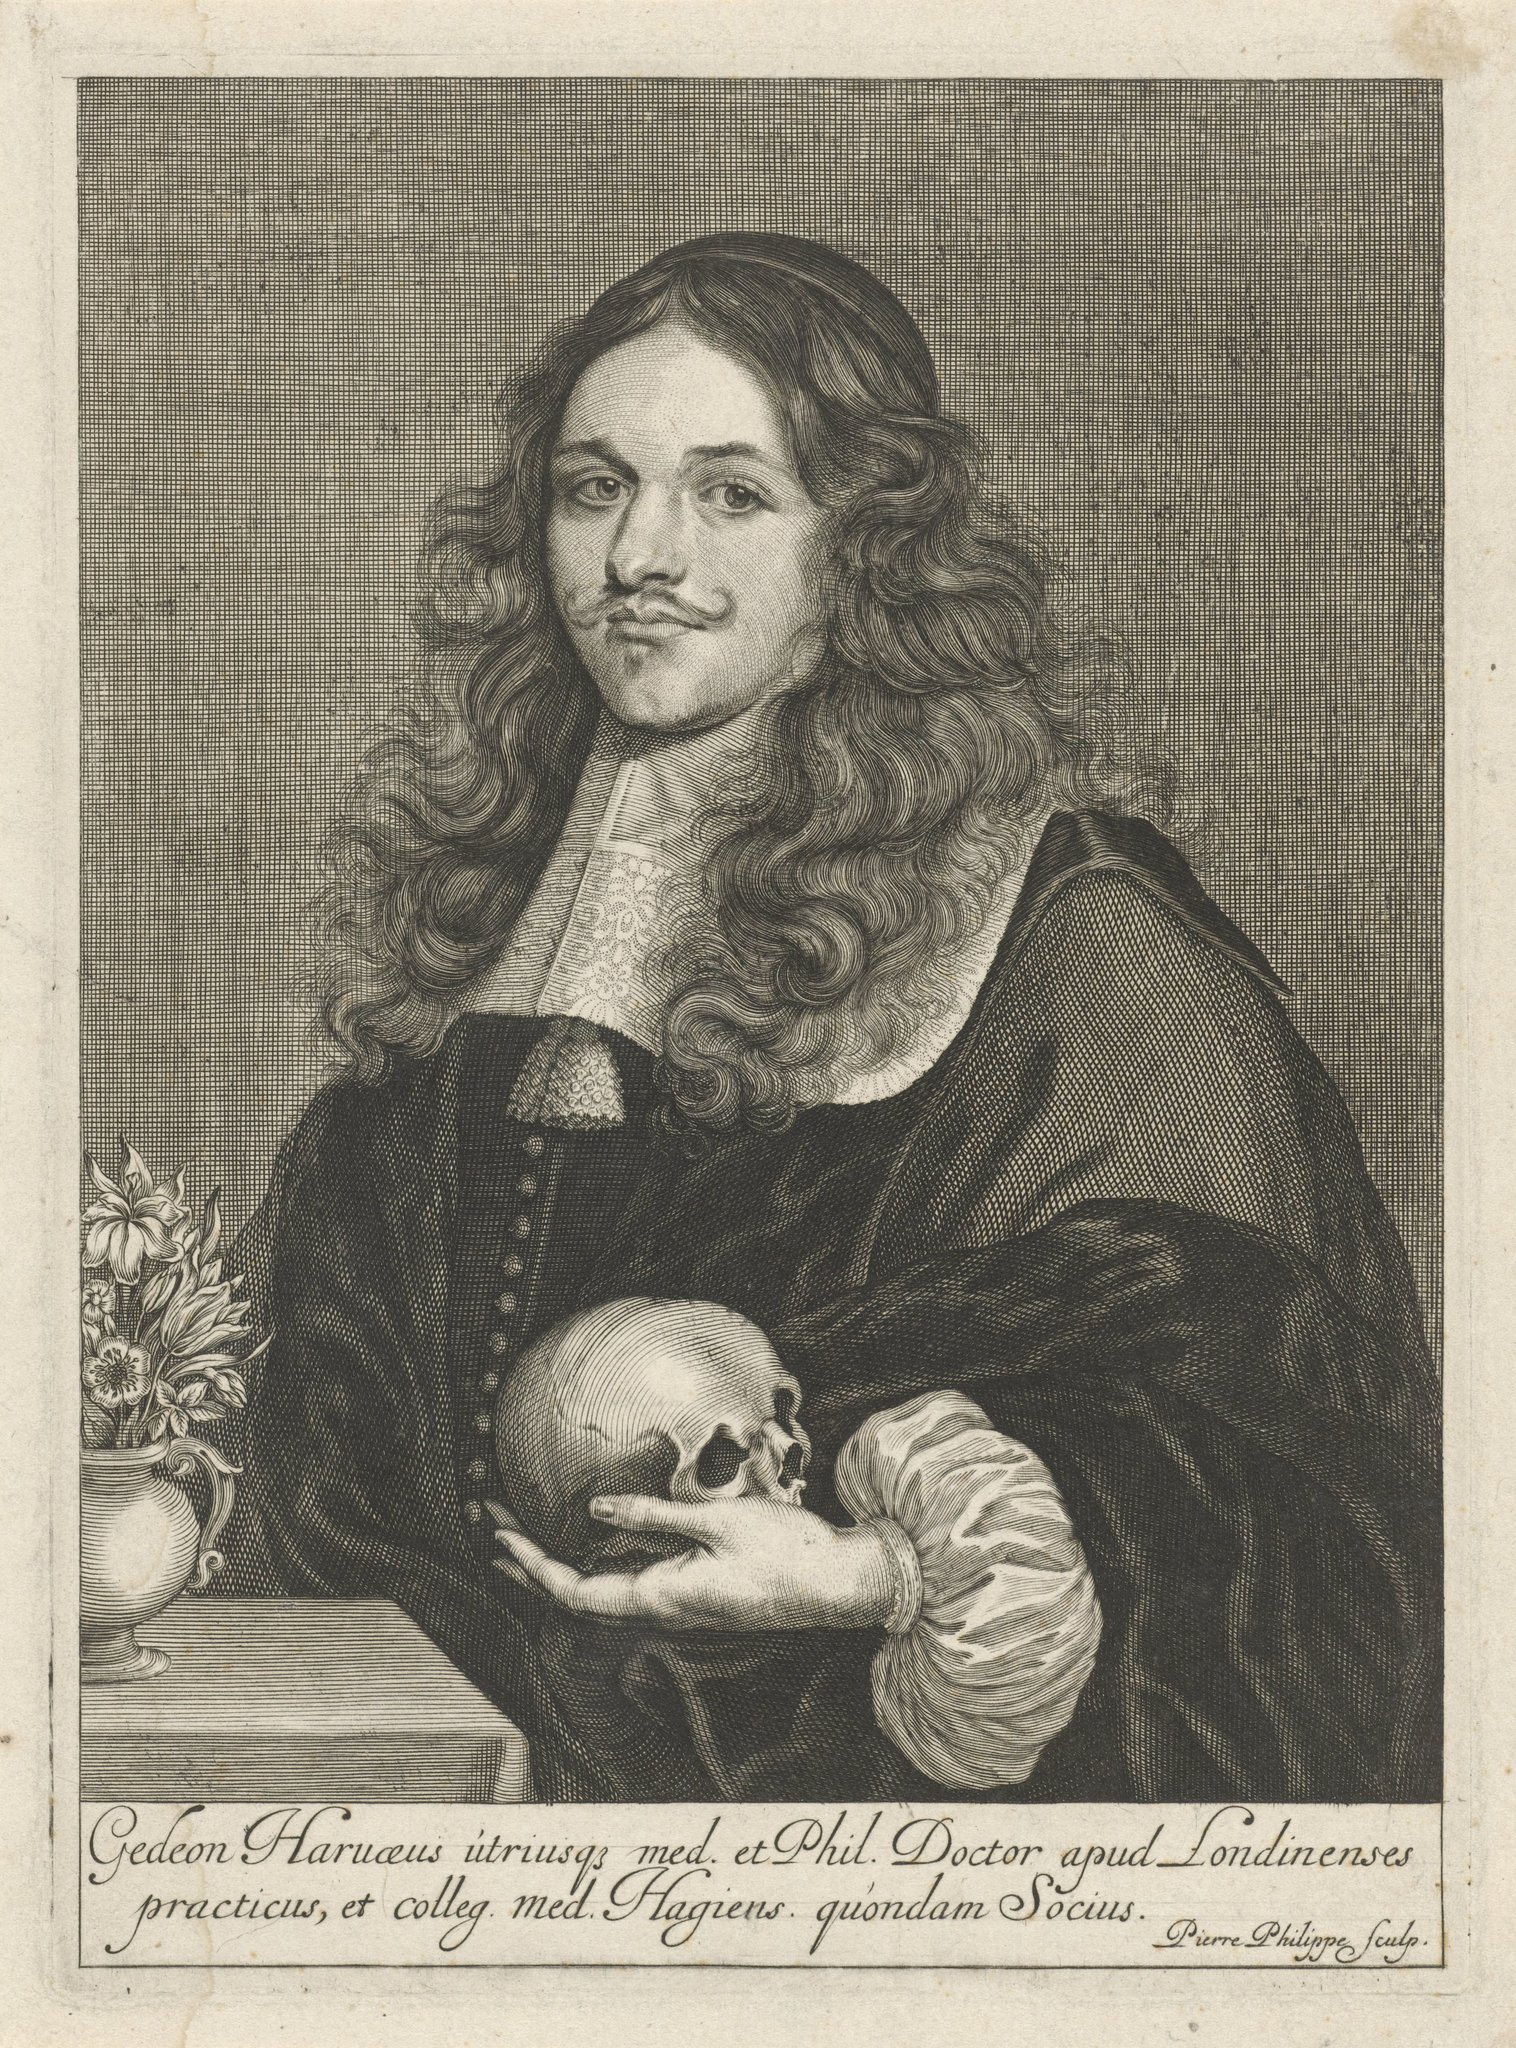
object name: print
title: Portret van Gideon Harvey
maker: pieter philippe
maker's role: print maker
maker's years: 1635-1702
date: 1663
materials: paper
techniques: engraving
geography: the hague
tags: skull as symbol of 'vanitas'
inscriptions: collector's mark: Lugt 2228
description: Prent ook gebruikt in: Harvey, Gideon, Archelogia philosophica nova; or, New principles of philosophy. S. Thomson, 1663.